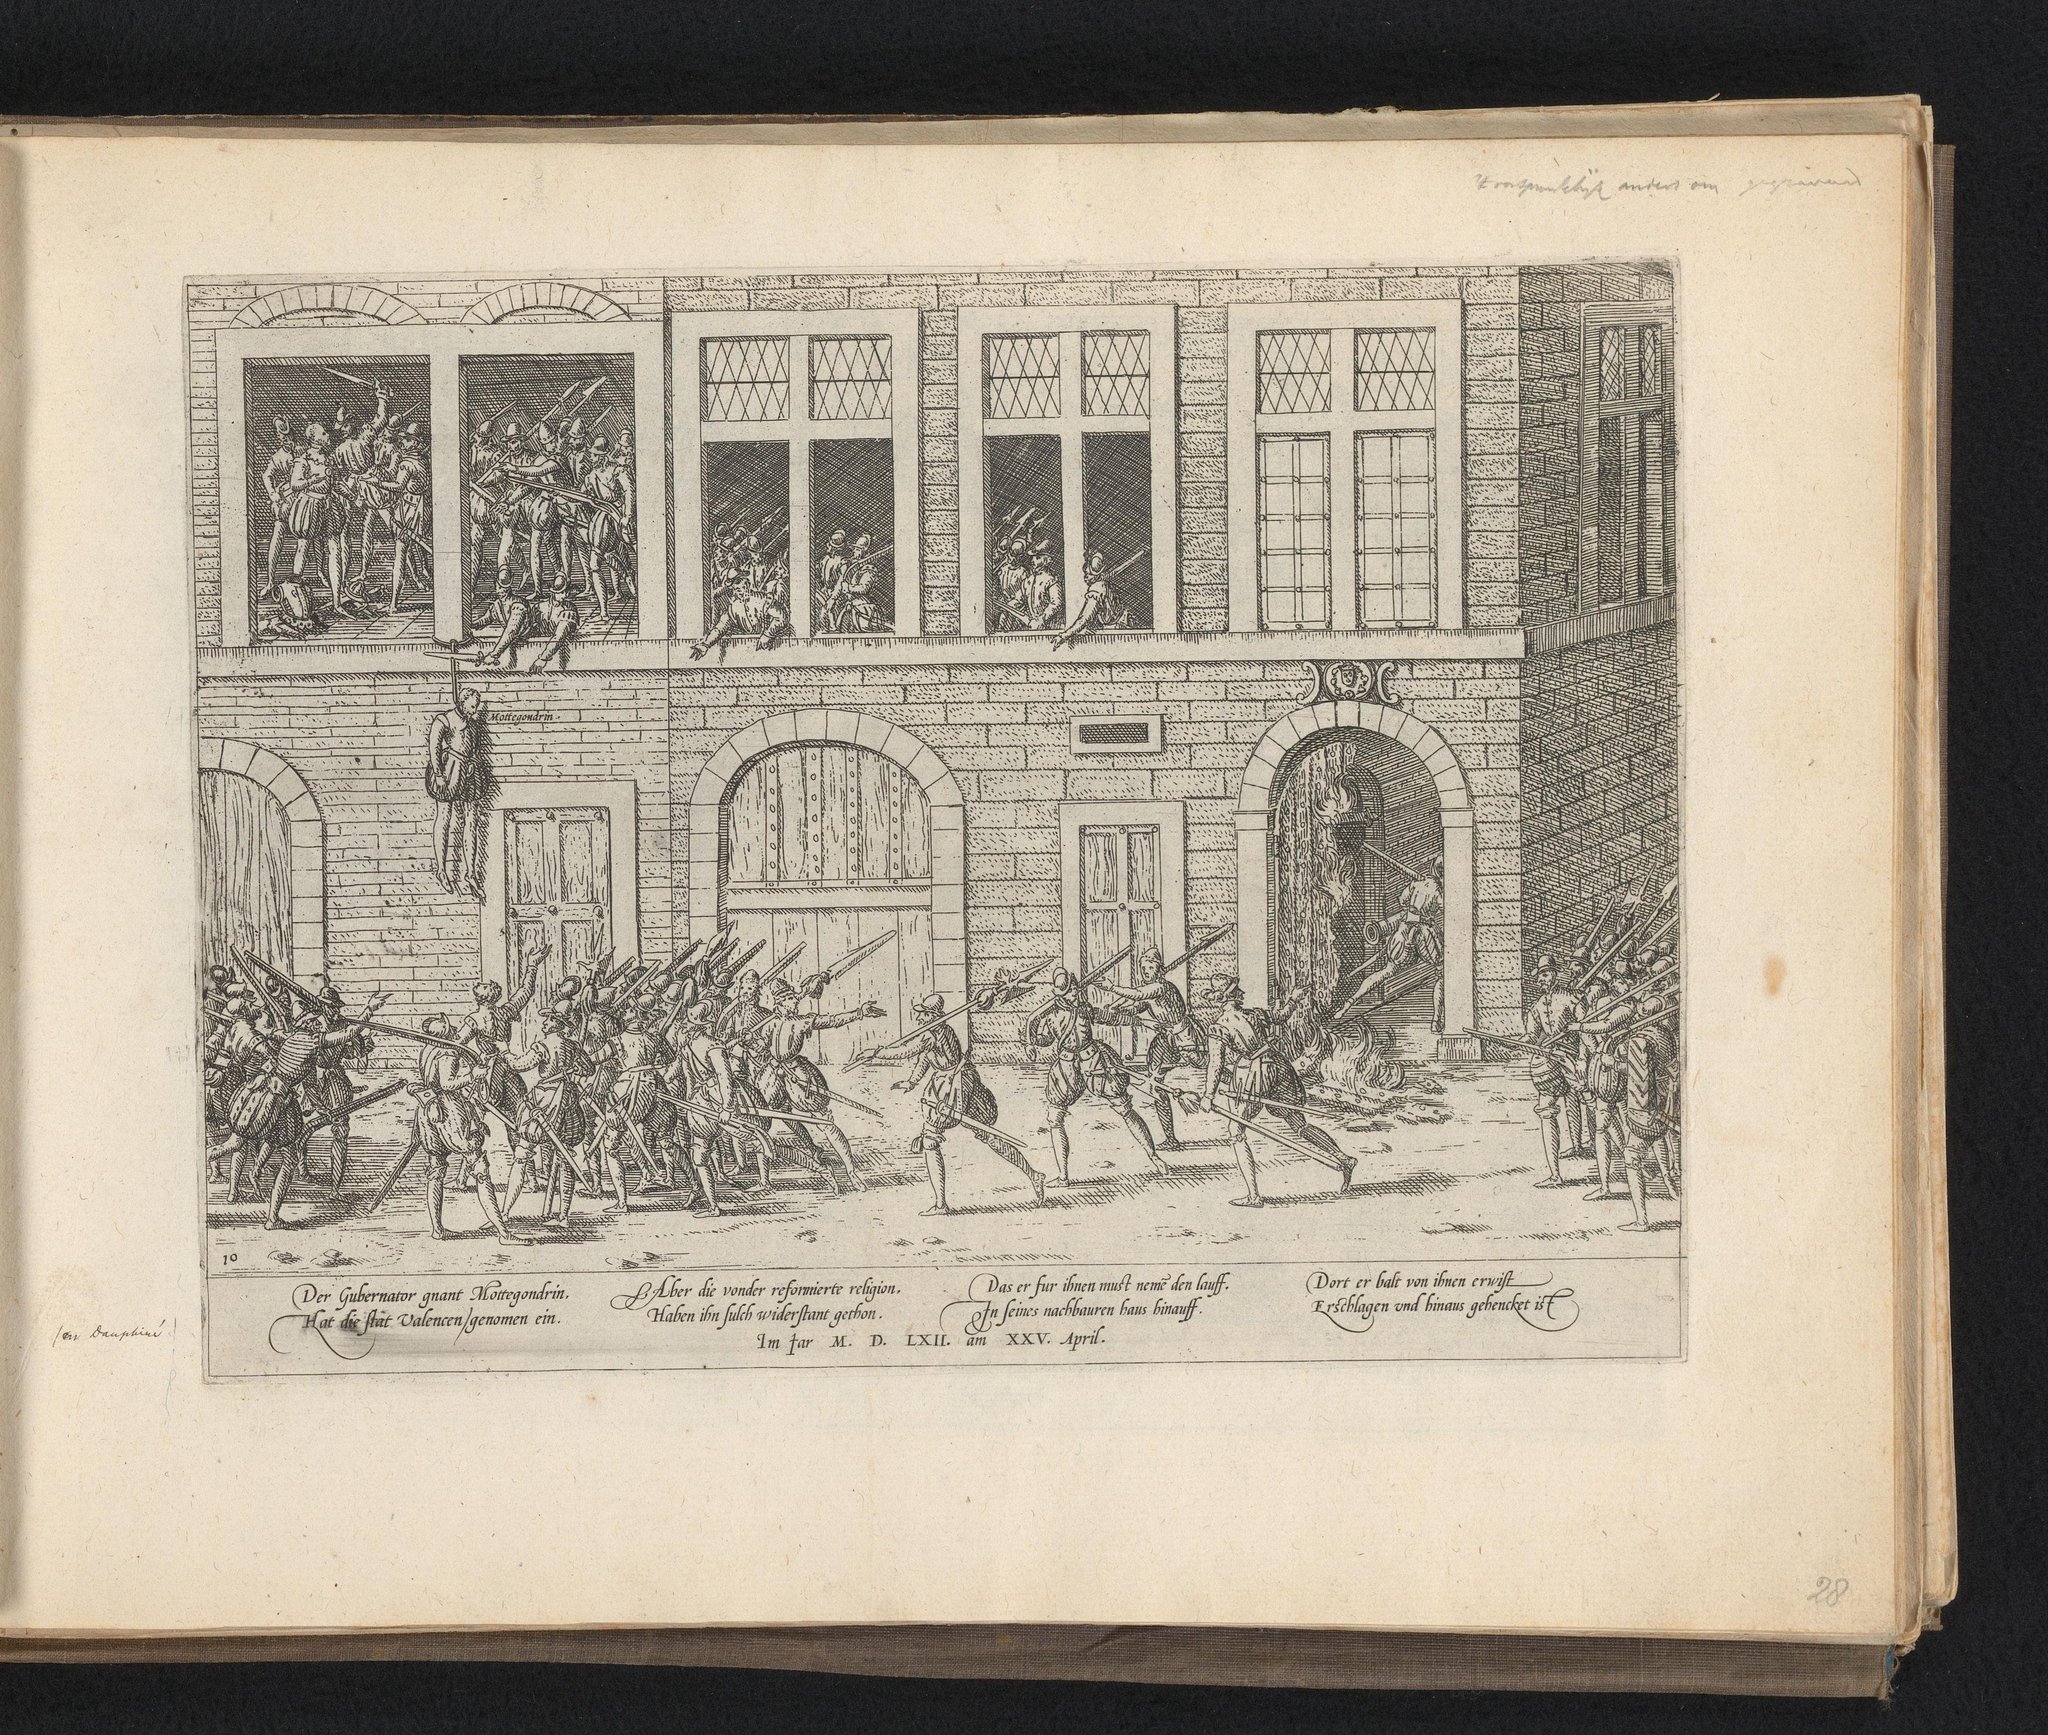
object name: album leaf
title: Serie 3: Franse Godsdienstoorlogen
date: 1562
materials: paper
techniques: etching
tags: violent death by hanging, militant proselytizing: religious war, crusade, etc., the roman catholic church vs. protestantism; (reformation and counter reformation)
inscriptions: annotation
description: Prent gebruikt in: Aitsinger, Michael. De Leone Belgico (...). Keulen: s.n., 1588.